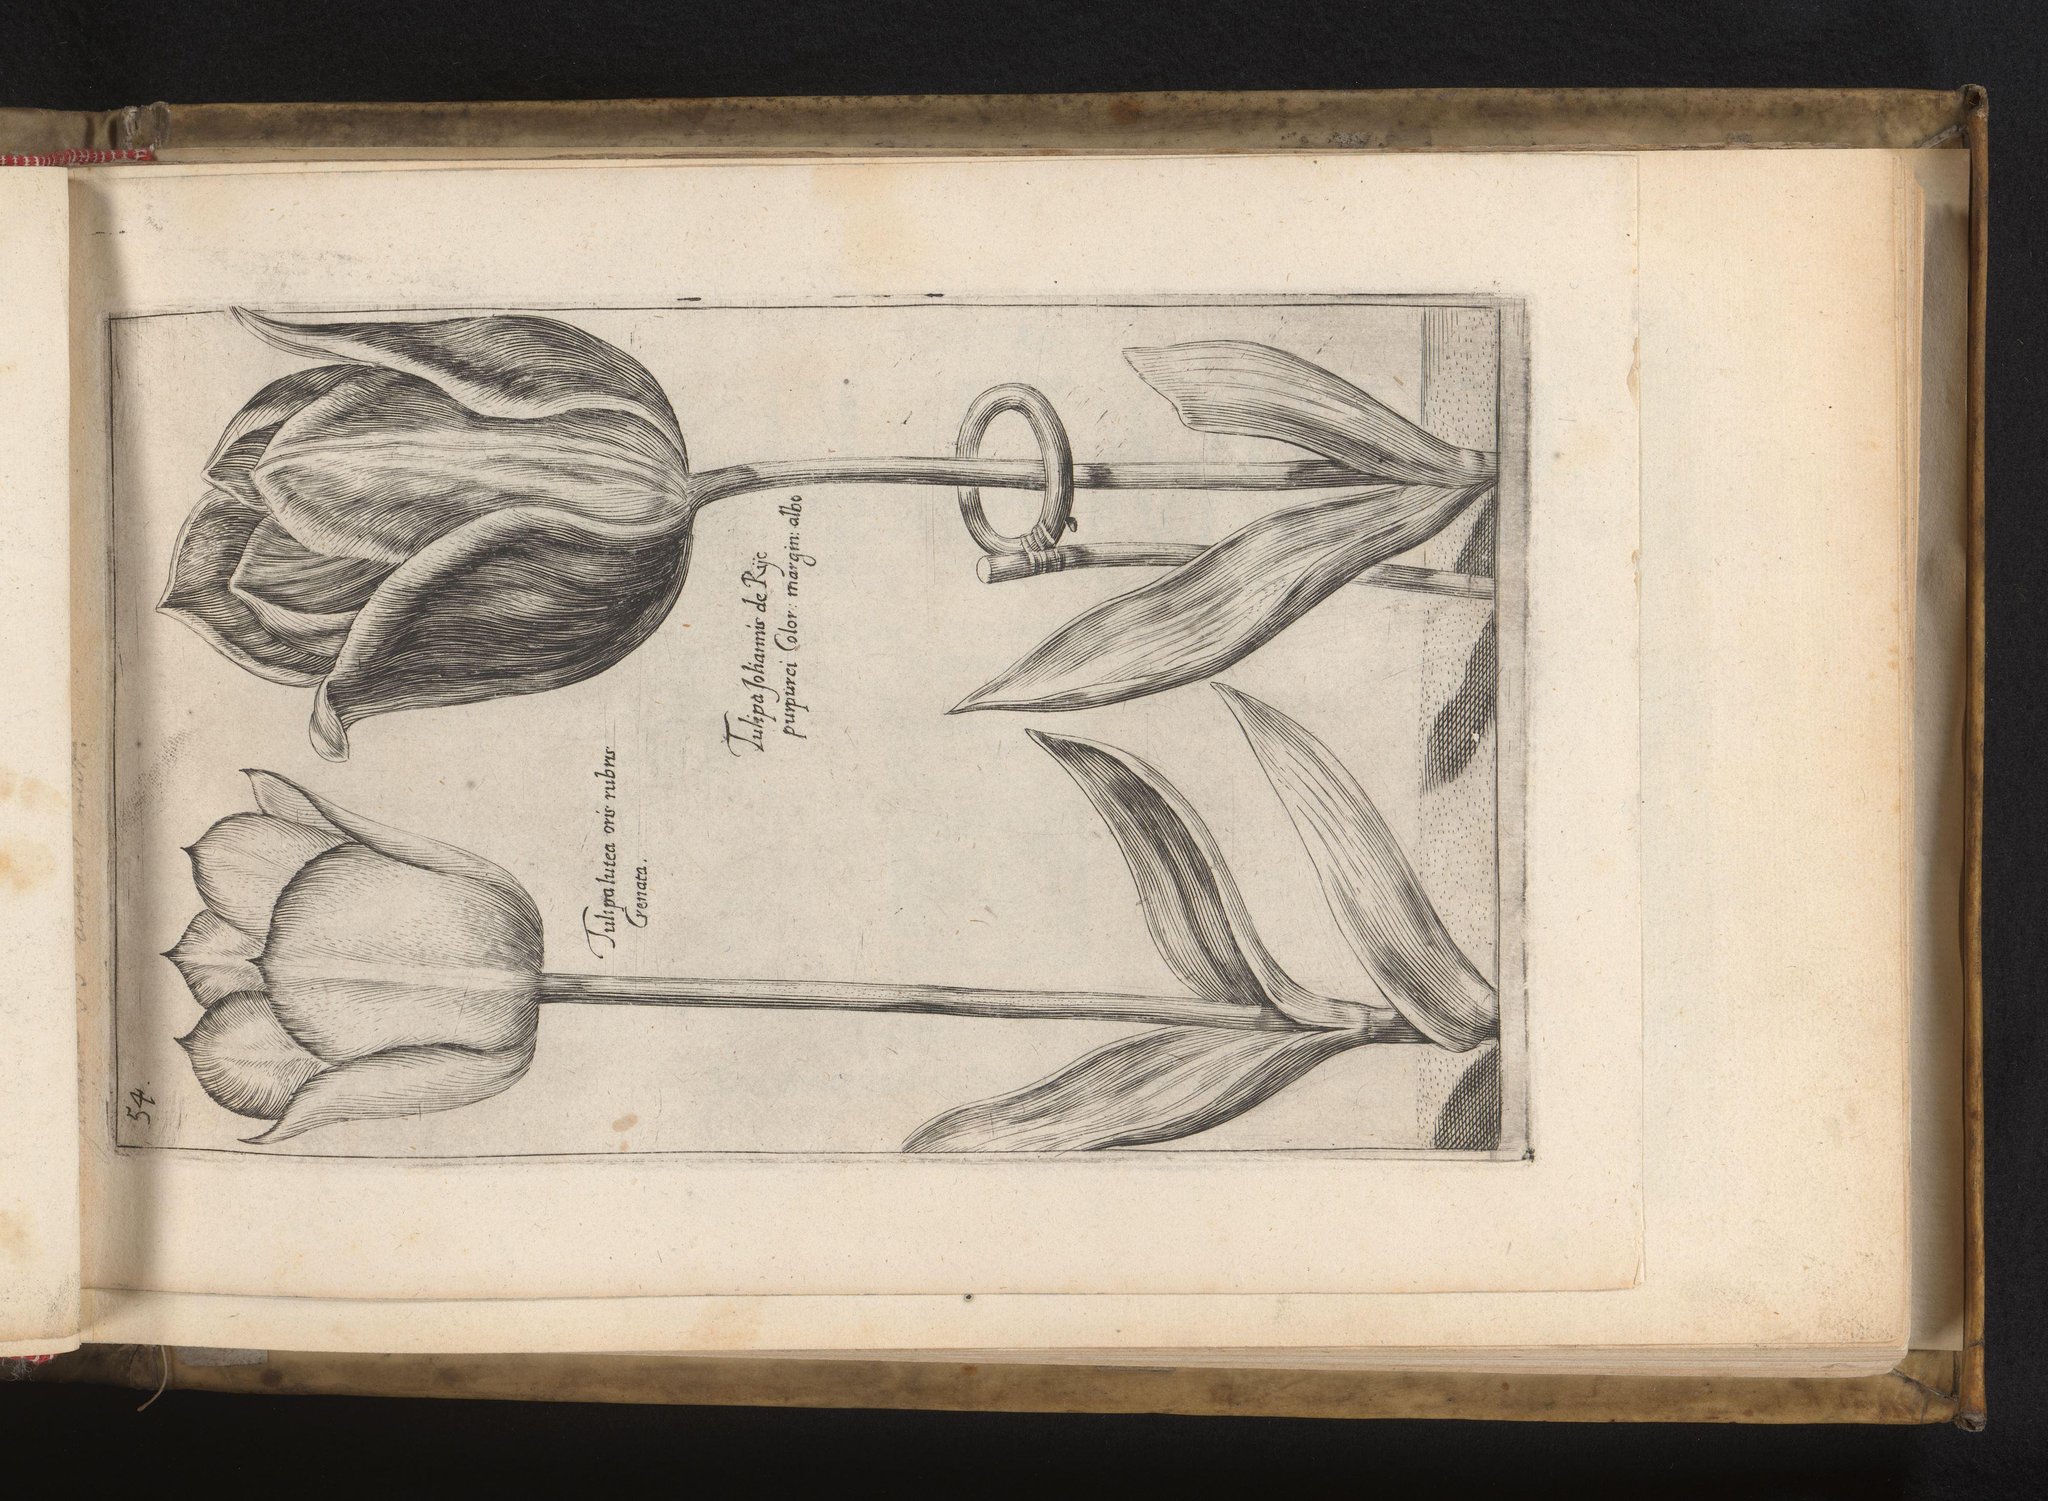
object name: page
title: Bloemtuin van de lente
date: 1617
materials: paper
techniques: engraving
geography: arnhem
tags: flowers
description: Prent uit: Passe, Crispijn van de (II). Hortus floridus in quo rariorum & minus vulgarium florum icones ad vivam veramque formam. Arnhem: Johannes Janssonius, 1617.